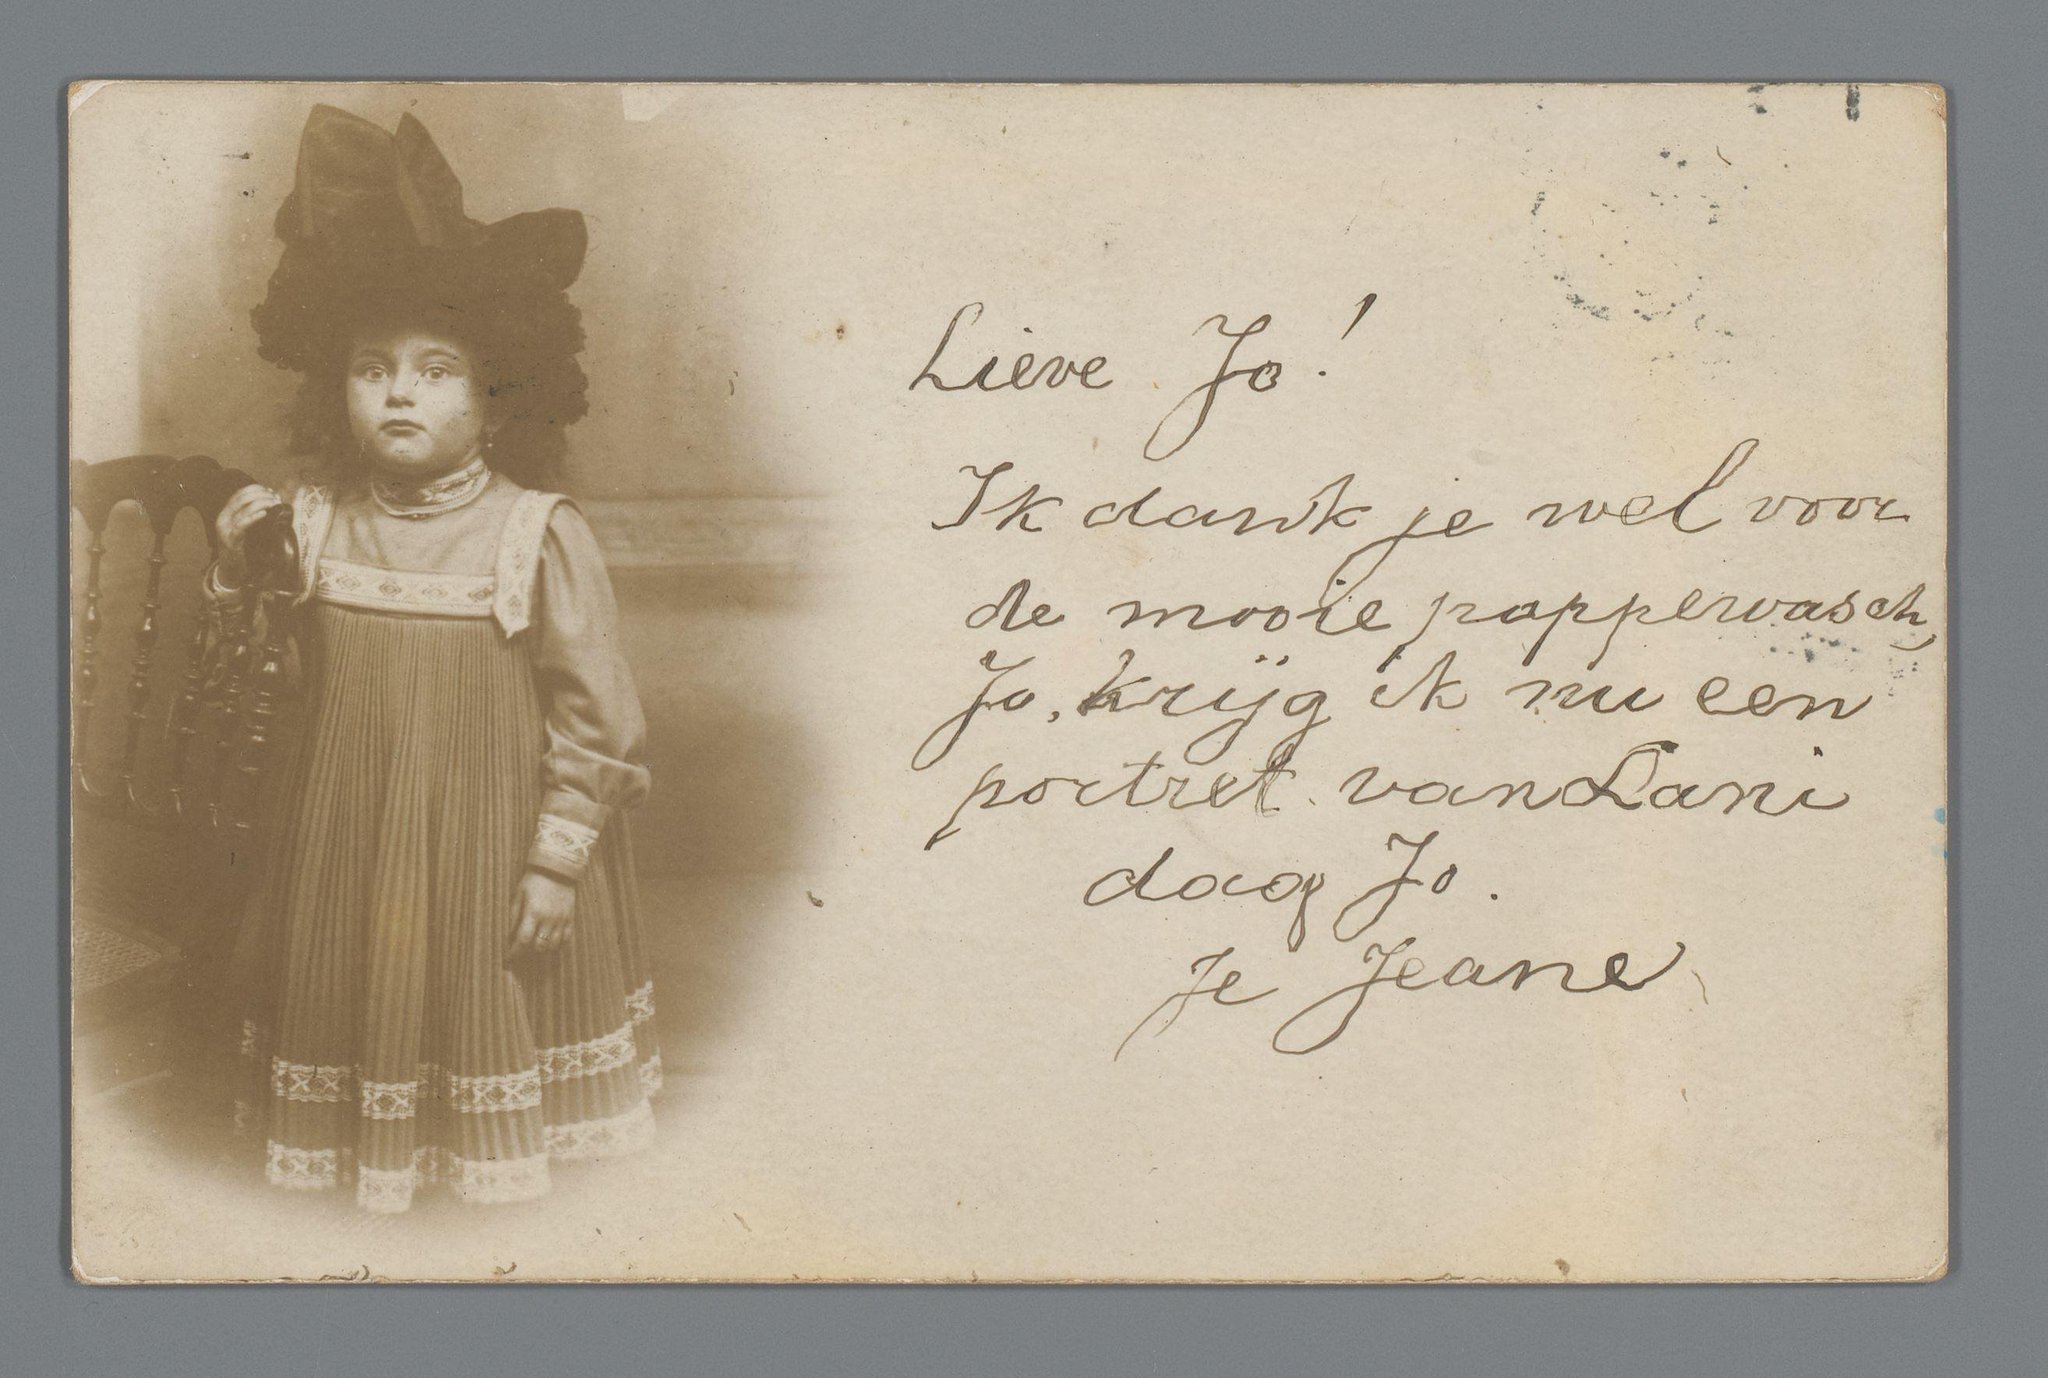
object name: ansichtkaart, prentbriefkaart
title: Portret van een onbekend meisje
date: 1903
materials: paper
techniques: gelatin silver print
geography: amsterdam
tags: girl (child between toddler and youth), anonymous historical person portrayed, amsterdam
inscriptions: inscription: ‘Lieve Jo!/ Ik dank je wel voor/ de mooie papperwasch,/ Jo, krijg ik nu een/ portret van Lani/ dag Jo./ Je Jeane’, inscription: ‘Mej. J. van Doesterling/ 3e Weteringdwarsstraat/ 26./ Hier’, inscription: ‘Snel-Photographie Electrique/ Kalverstraat 191, Amsterdam.’